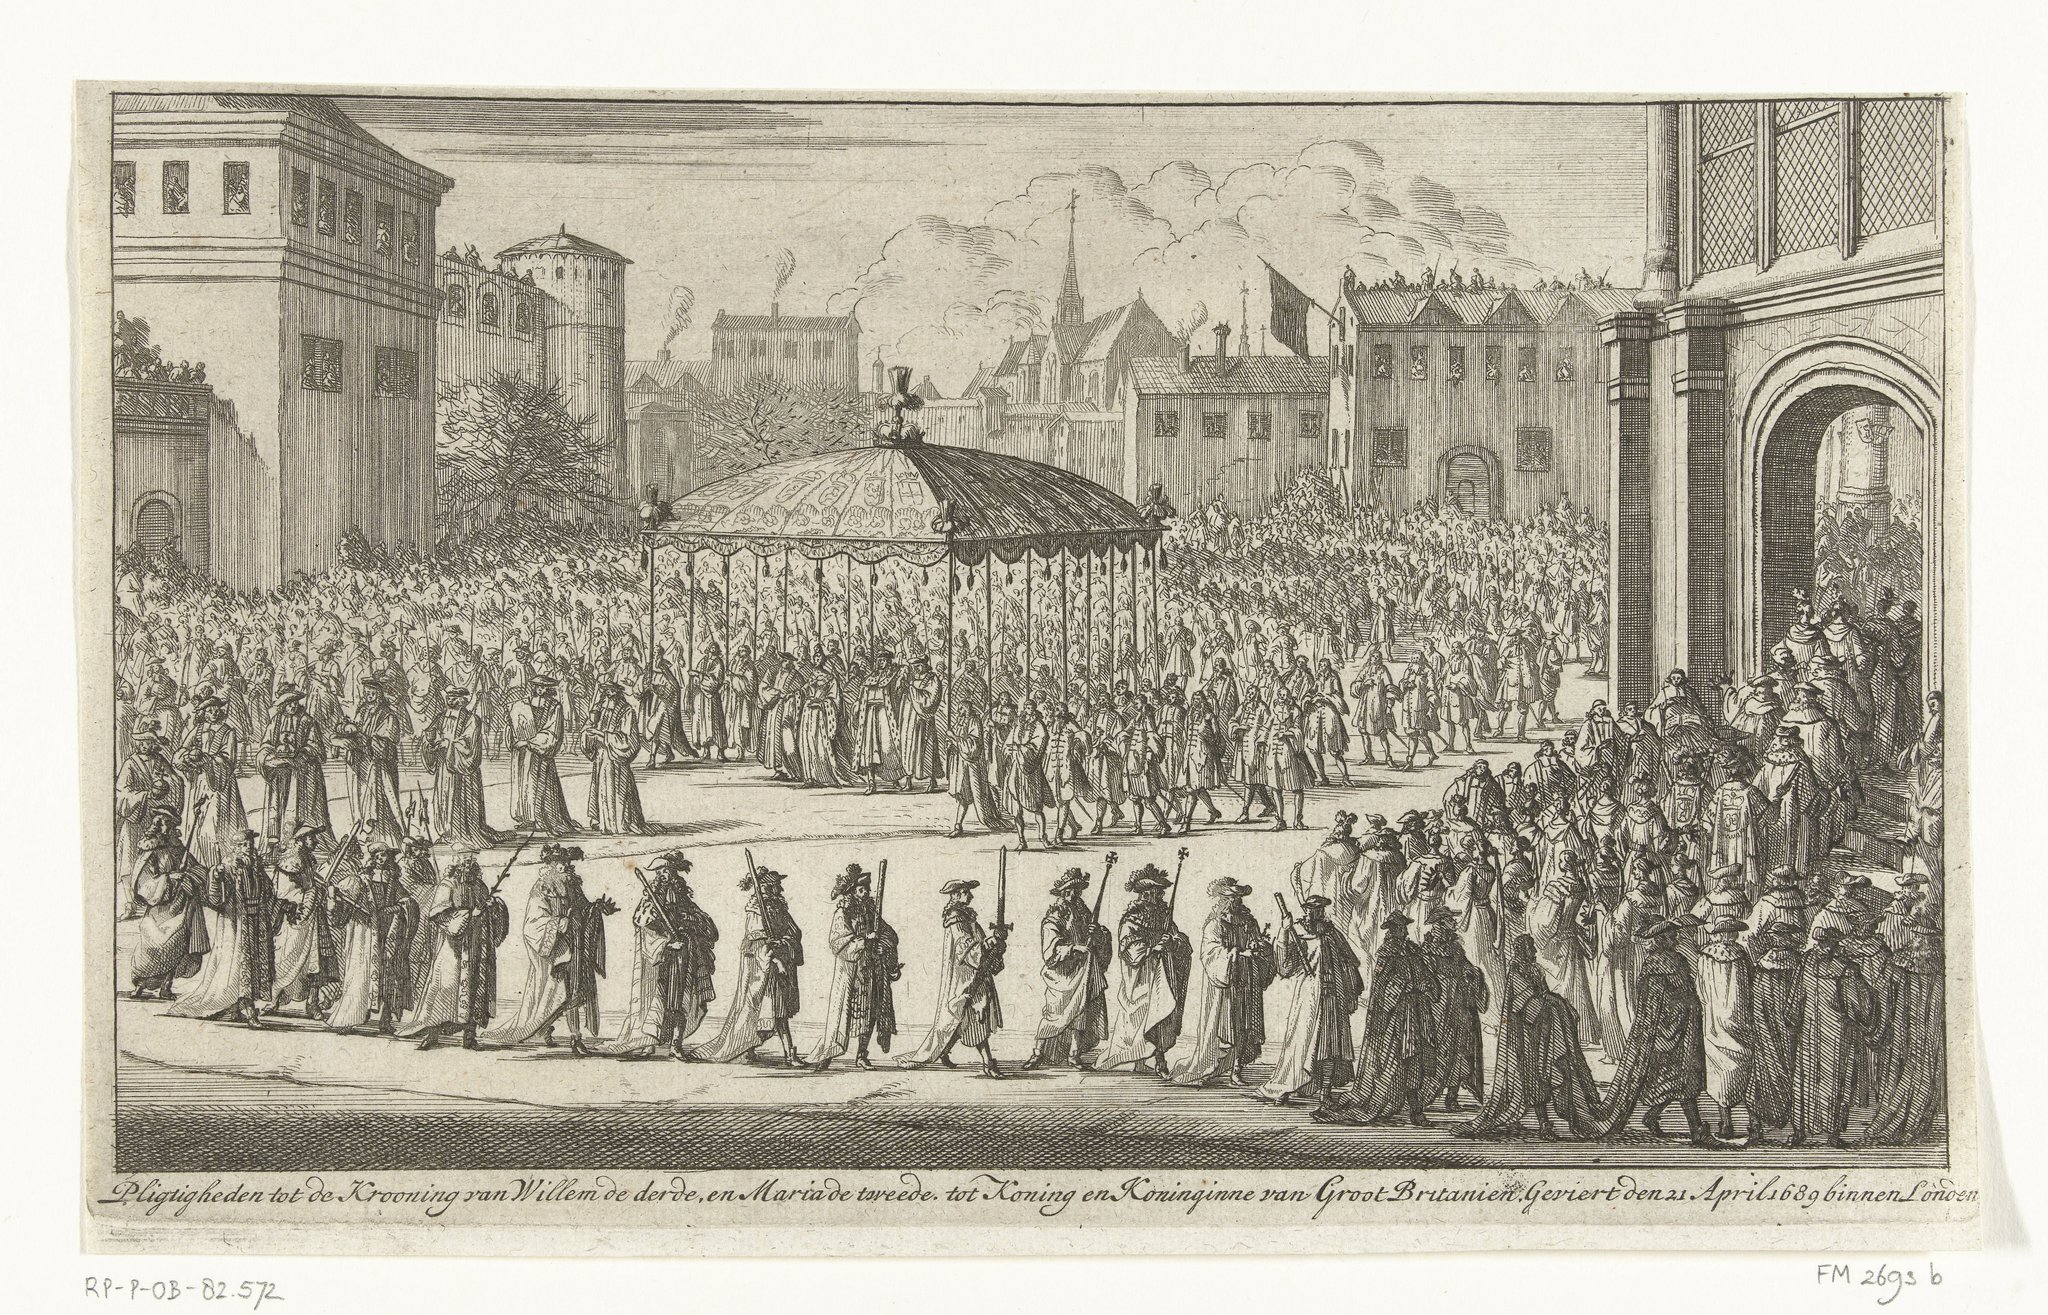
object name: print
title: Pligtigheden tot de Krooning van Willem de derde, en Maria de tweede, tot Koning en Koninginne van Groot-Britanien, Geviert den 21 April 1689 binnen Londen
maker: jan luyken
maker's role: draughtsman, print maker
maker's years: 1649-1712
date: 1692-1694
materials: paper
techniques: engraving, etching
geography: northern netherlands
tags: the hague, william iii (prince of orange and king of england, scotland, and ireland), london, maria ii stuart (koningin van engeland, schotland en ierland), coronation procession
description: Gebruikt als illustratie in: Lambert van den Bosch, Het leven en bedryf van Willem de Darde, Jan Claesz ten Hoorn, Amsterdam 1694, 4 delen, dl. 2, p. 289. Herhaling of kopie van de prent oorspronkelijk gebruikt als illustratie in: Engeland beroerd onder de regeering van koning Jacobus de II. En hersteld door Willem en Maria, prins en princesse van Orangie, Jan Claesz ten Hoorn, Amsterdam 1689 (zie FMH 2693a/8).